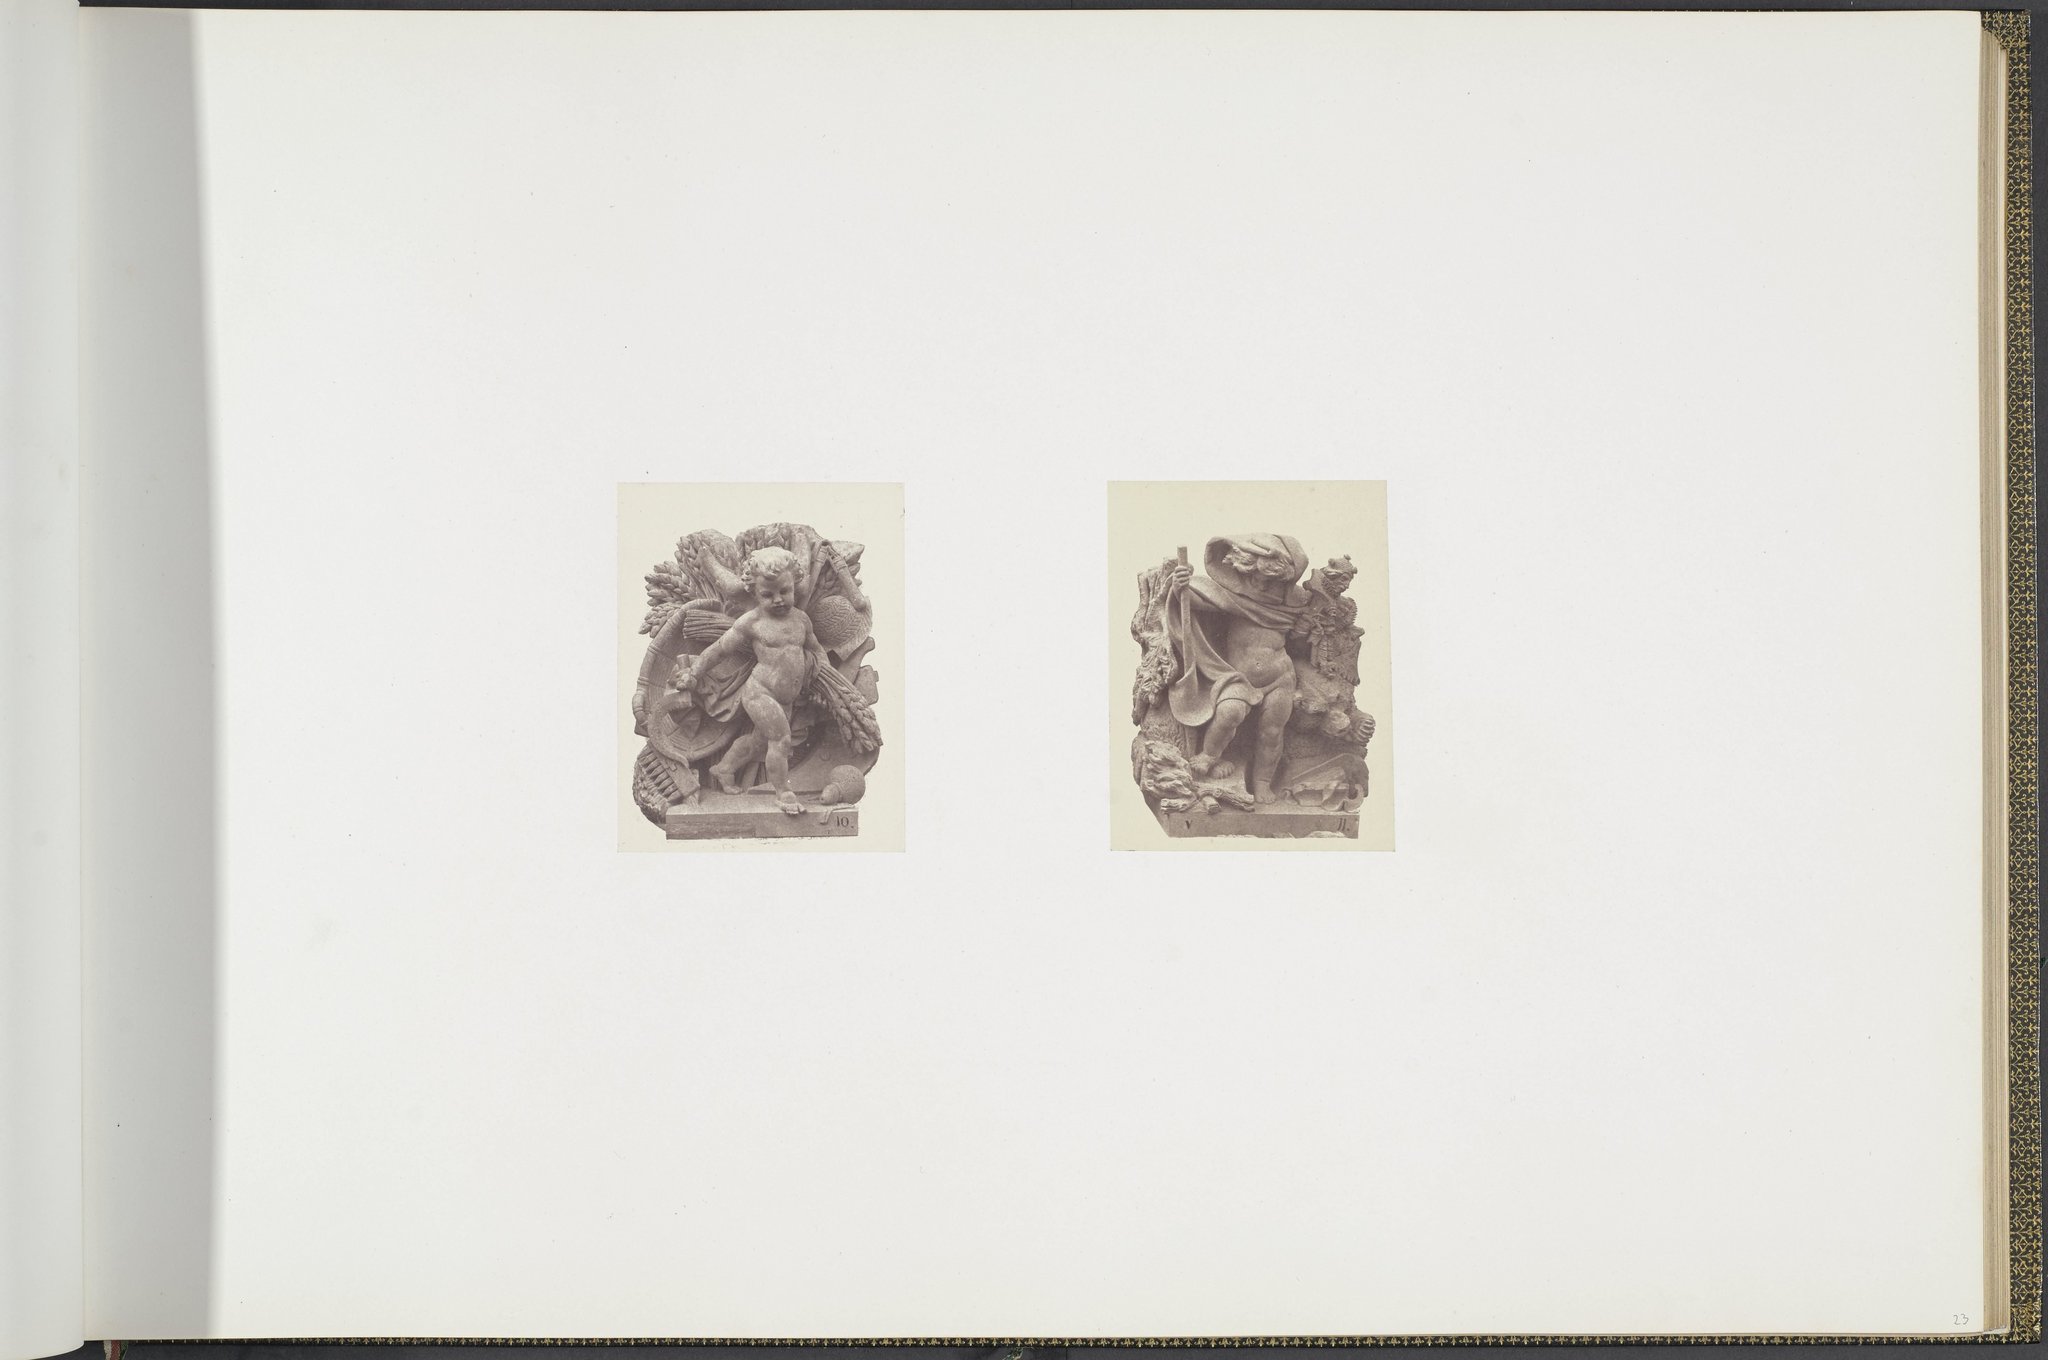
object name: album leaf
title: Gipsmodellen voor beeldhouwwerken op het Palais du Louvre: links "La Moisson"door Alexandre Schoenewerk en rechts "L'Hiver" door Georges Clère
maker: édouard denis baldus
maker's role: fotograaf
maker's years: 1813-1889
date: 1855-1857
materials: paper, photographic support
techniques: salted paper print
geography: paris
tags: piece of sculpture, reproduction of a piece of sculpture, permanent exhibition, museum, paris, tuileries palace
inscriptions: number: ‘10 en V 11’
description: Onderdeel van Réunion des Tuileries au Louvre 1852-1857, album 1.